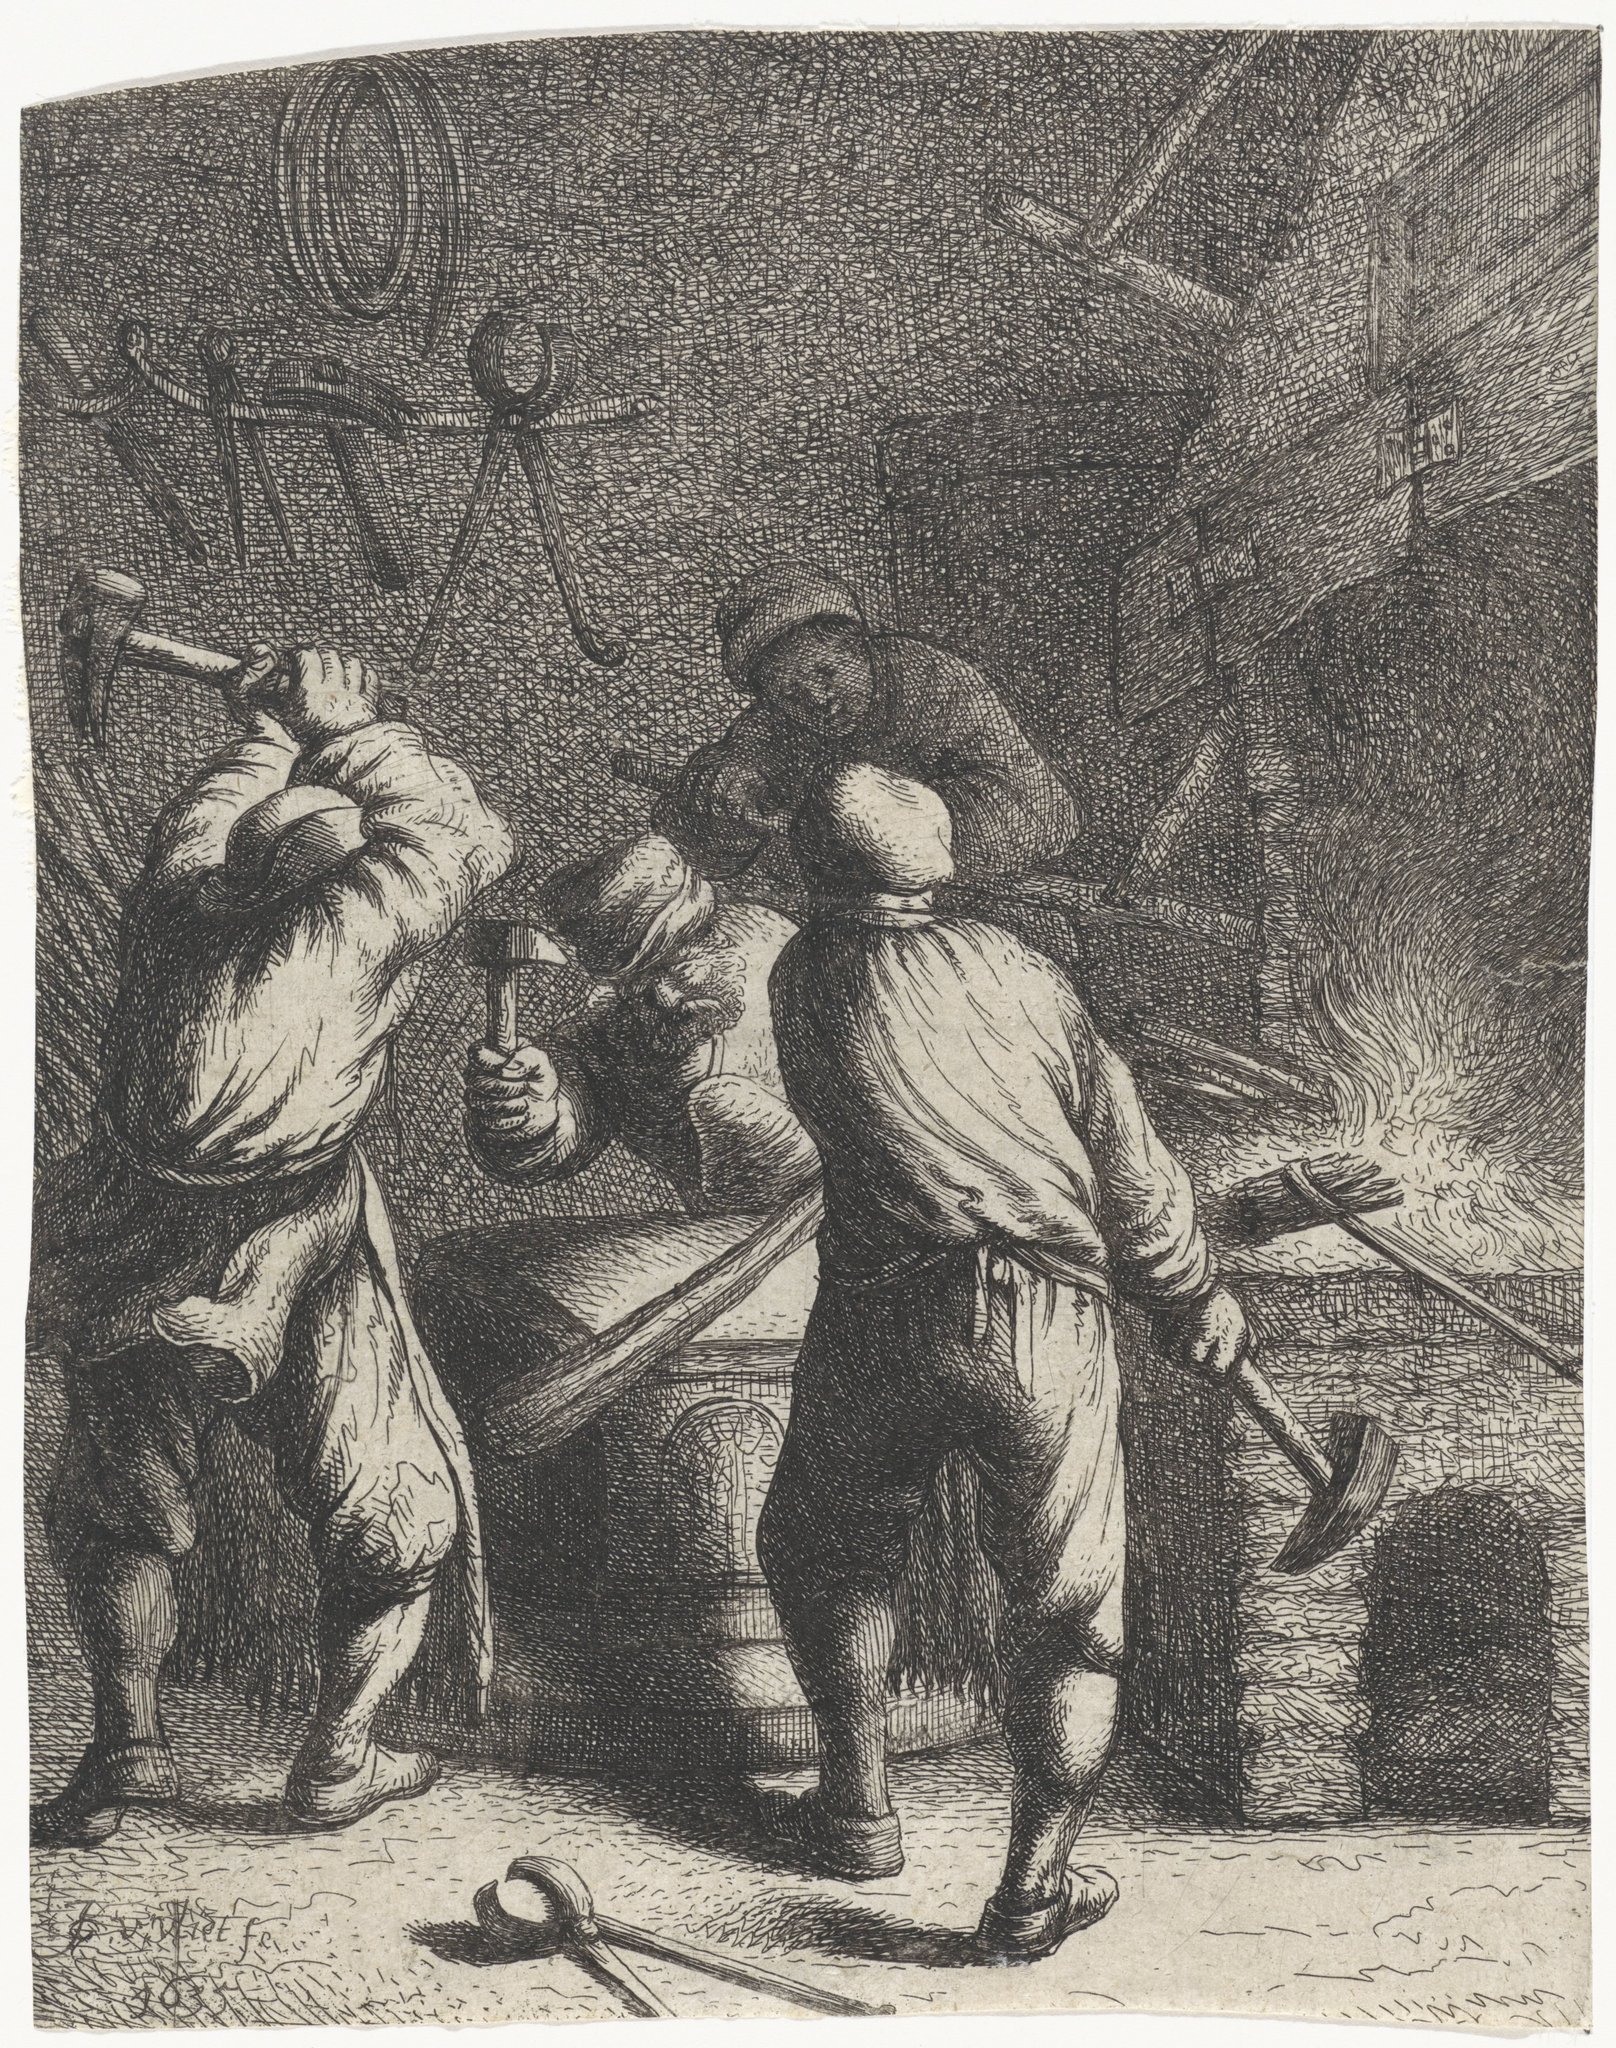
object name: print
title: Smeden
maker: jan gillisz. van vliet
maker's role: draughtsman, painter, print maker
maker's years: 1600-1668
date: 1635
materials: paper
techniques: etching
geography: leiden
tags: tools, aids, implements ~ crafts and industries: tongs, tools, aids, implements ~ crafts and industries: hammer, smith, blacksmith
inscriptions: collector's mark: Lugt 2228